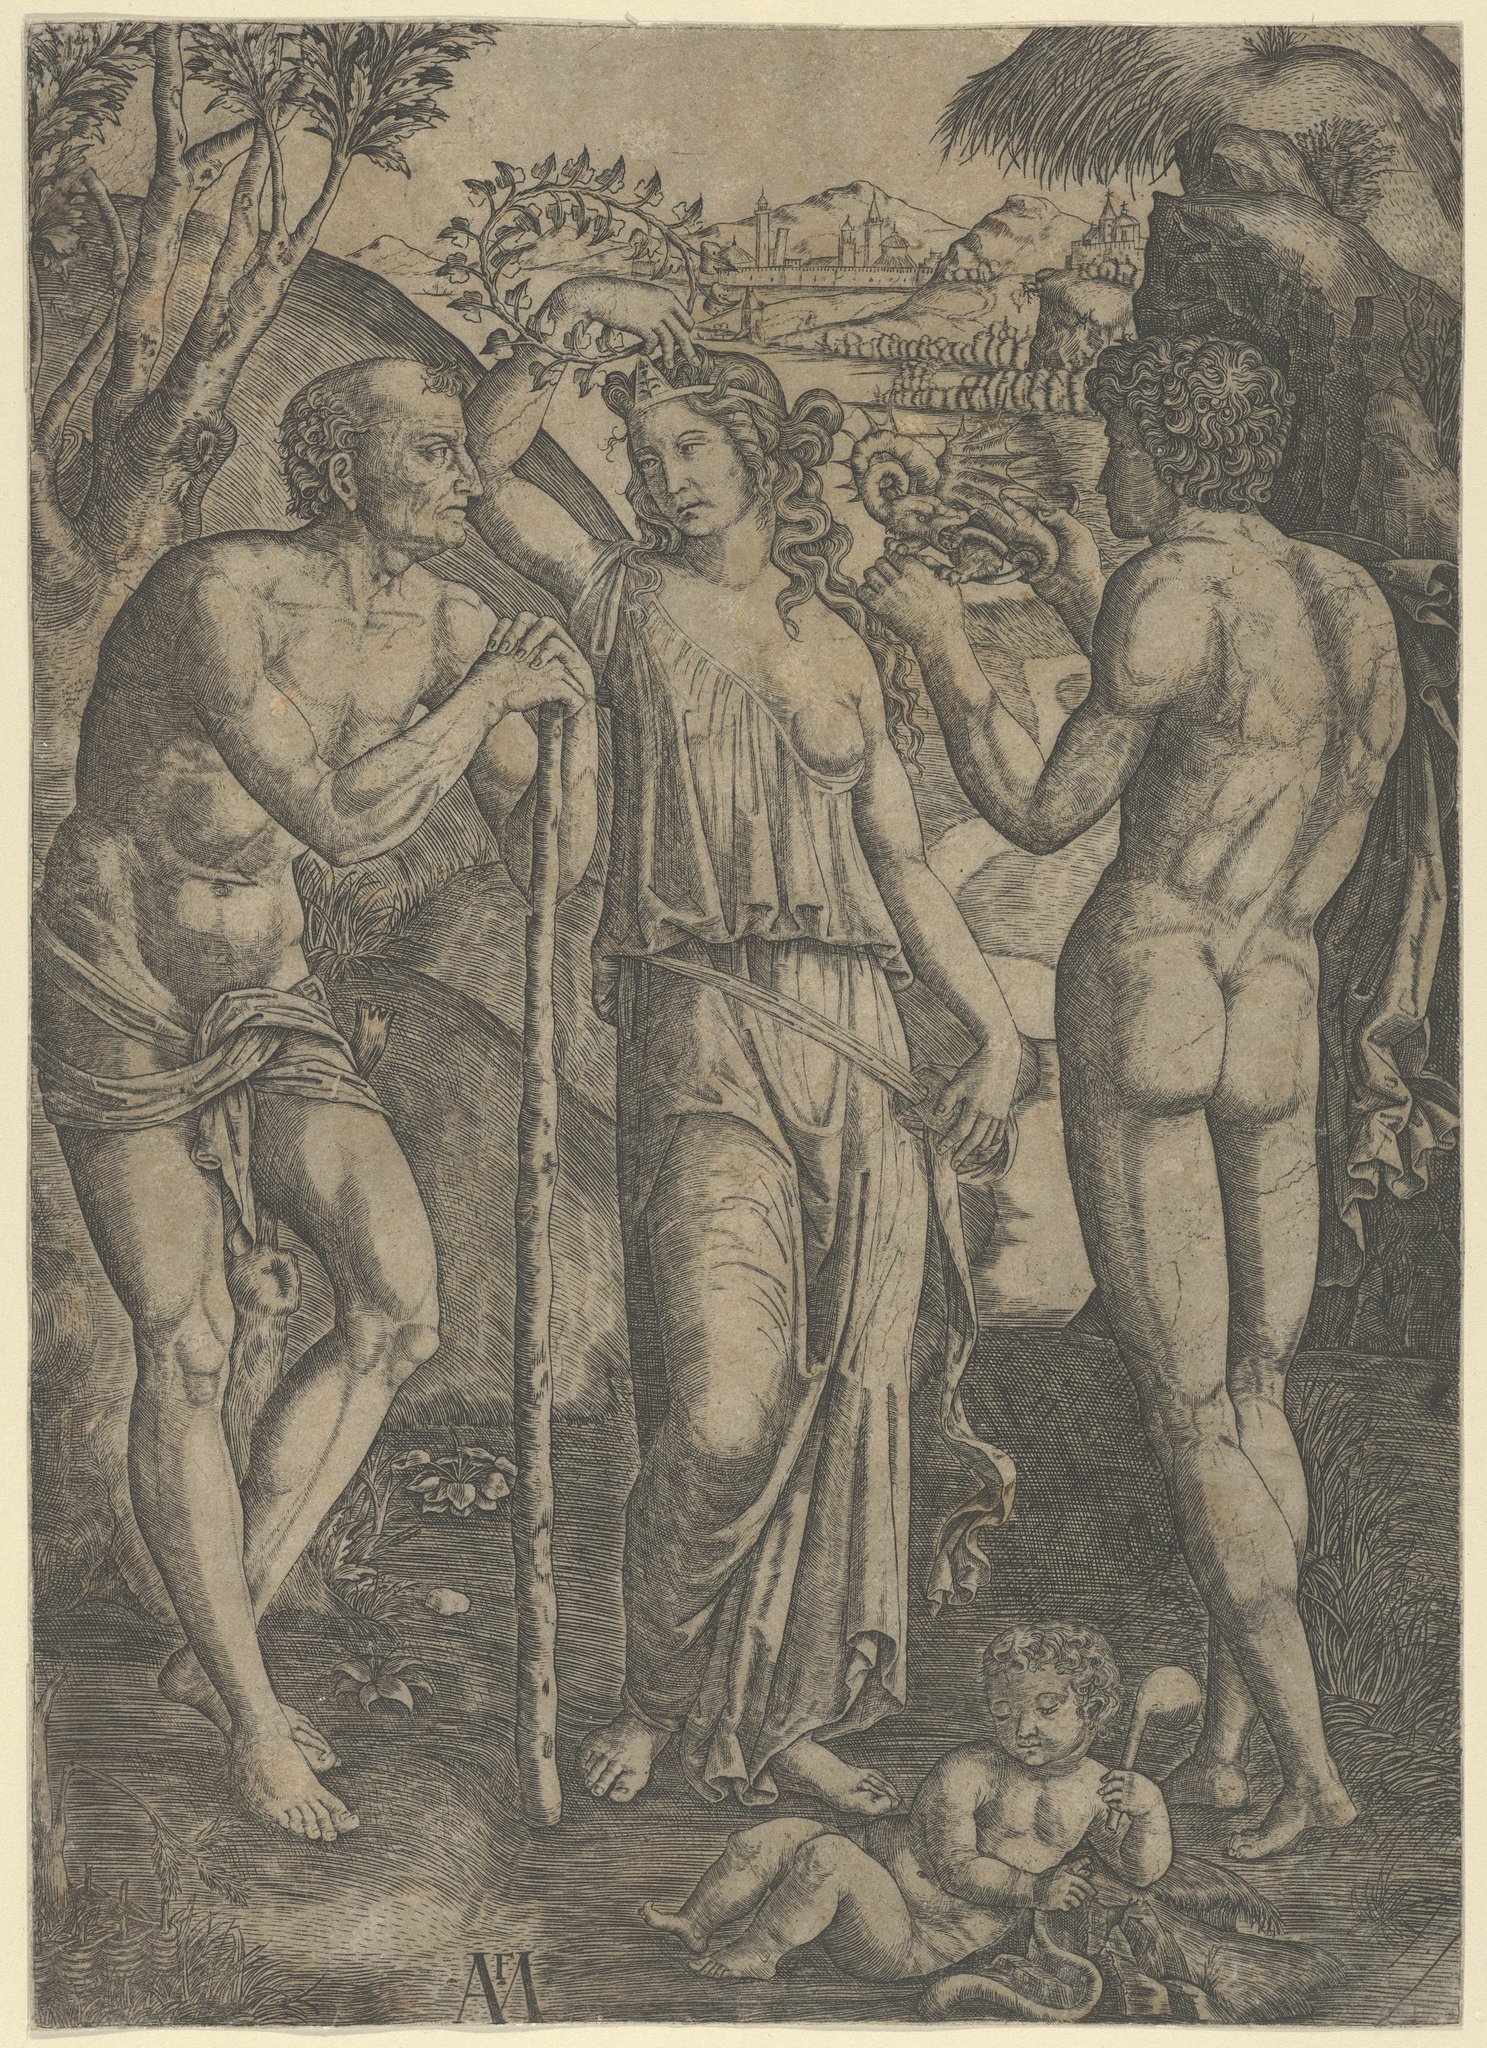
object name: print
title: An allegorical scene; a young woman at centre holding a wreath above her head, at left is a old man leaning on a stick, a younger man at right who holds a small dragon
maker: marcantonio raimondi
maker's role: artist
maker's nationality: italian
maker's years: 1475-1534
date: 1515-1527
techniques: engraving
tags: infants,men,male nudes,women,dragons